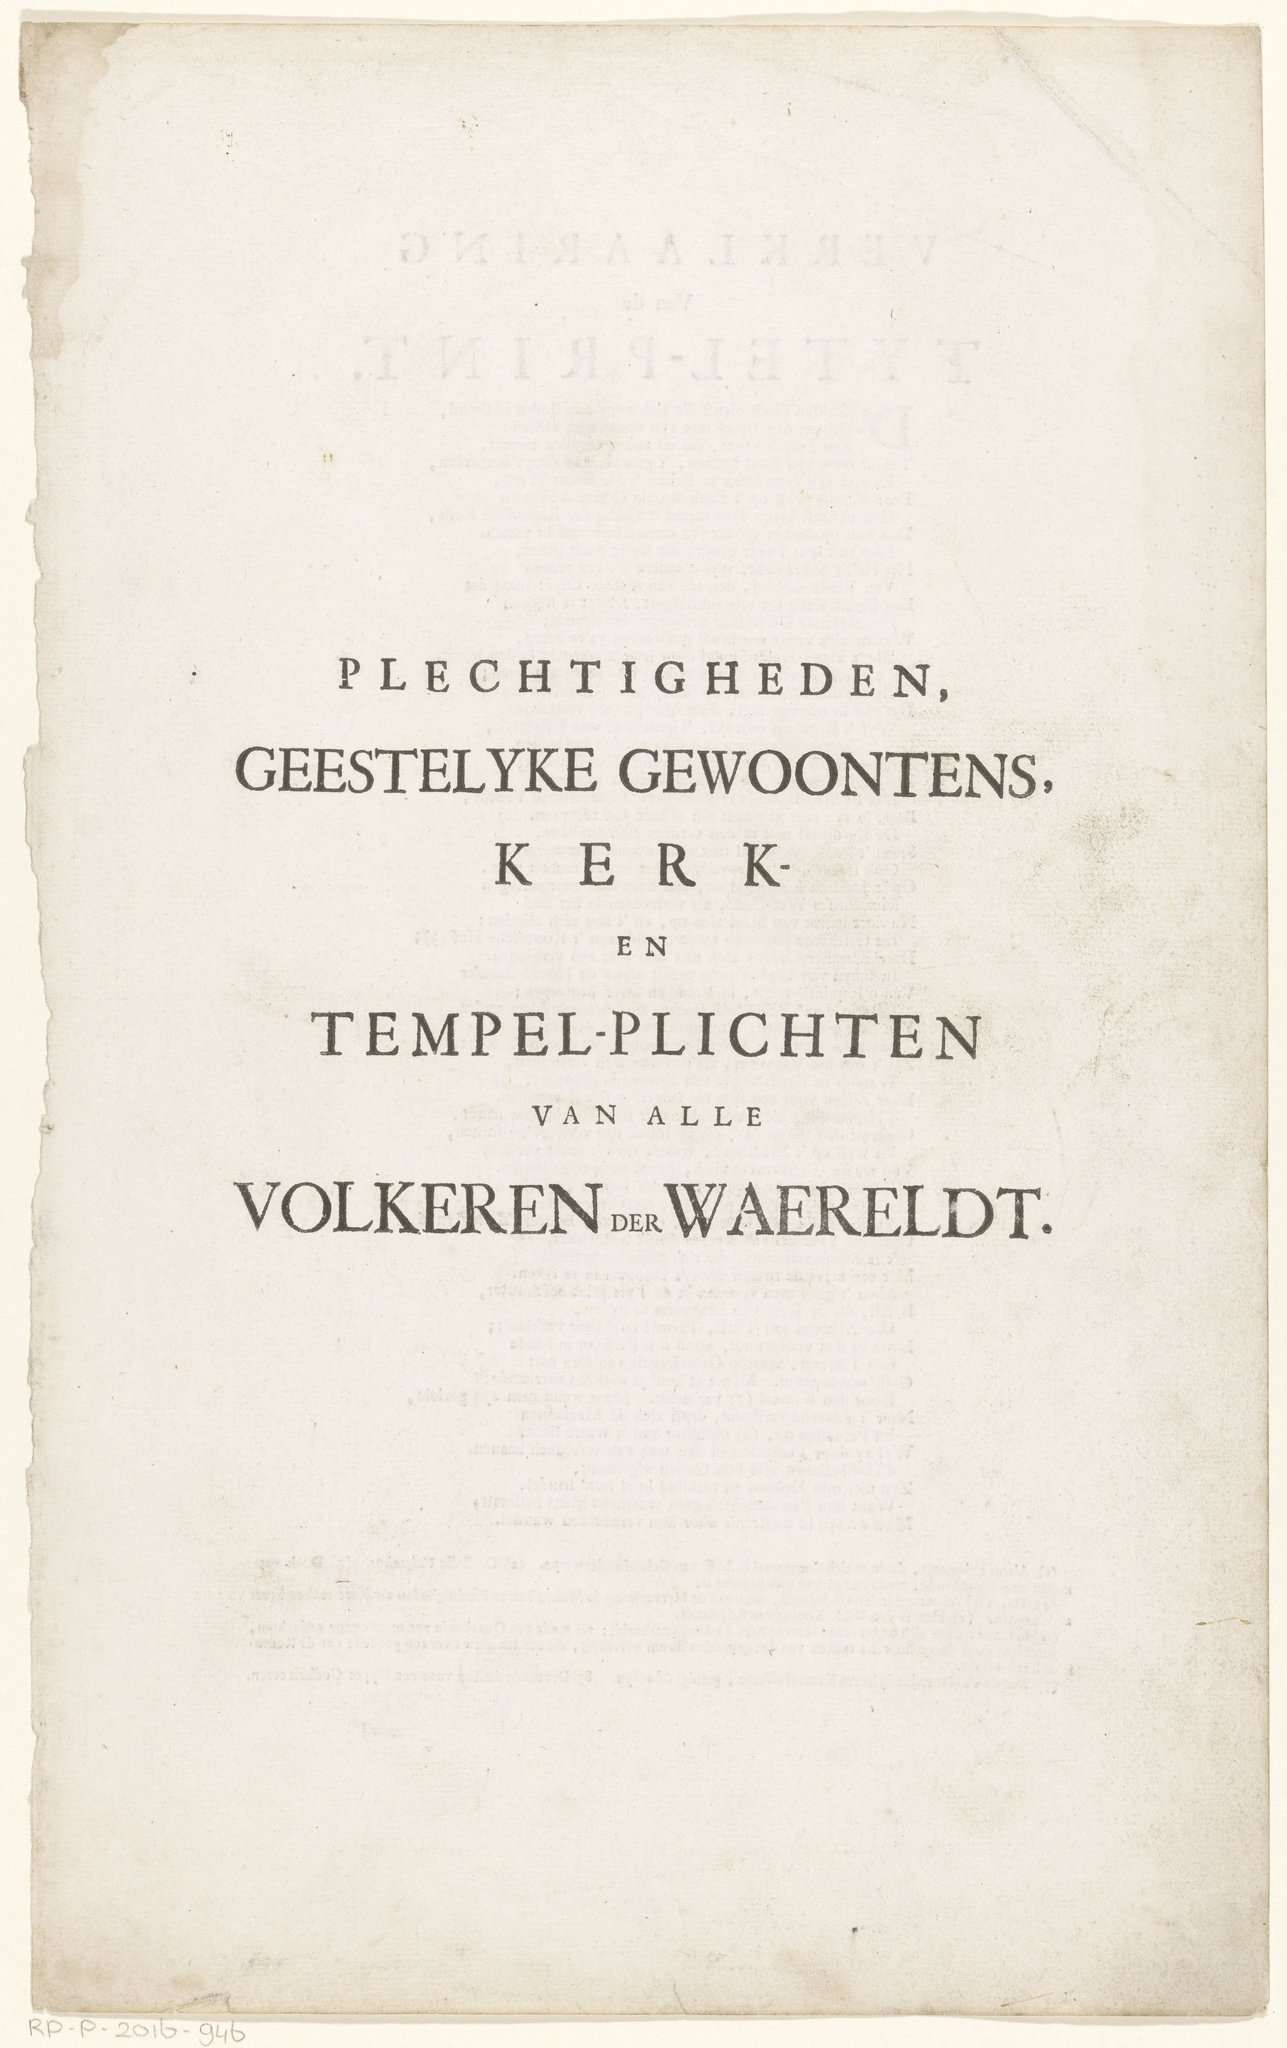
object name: print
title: Titelpagina voor: A. Moubach, Naaukeurige beschryving der uitwendige godtsdiens-plichten, kerk-zeden en gewoontens van alle volkeren der waereldt, 1727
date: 1727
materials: paper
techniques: letterpress printing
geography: amsterdam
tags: title-page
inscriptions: collector's mark: Lugt 2760, collector's mark: Lugt 2228, inscription: ‘28-11-85 / 1+2’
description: Titelpagina en verso verklaring van titelprent.